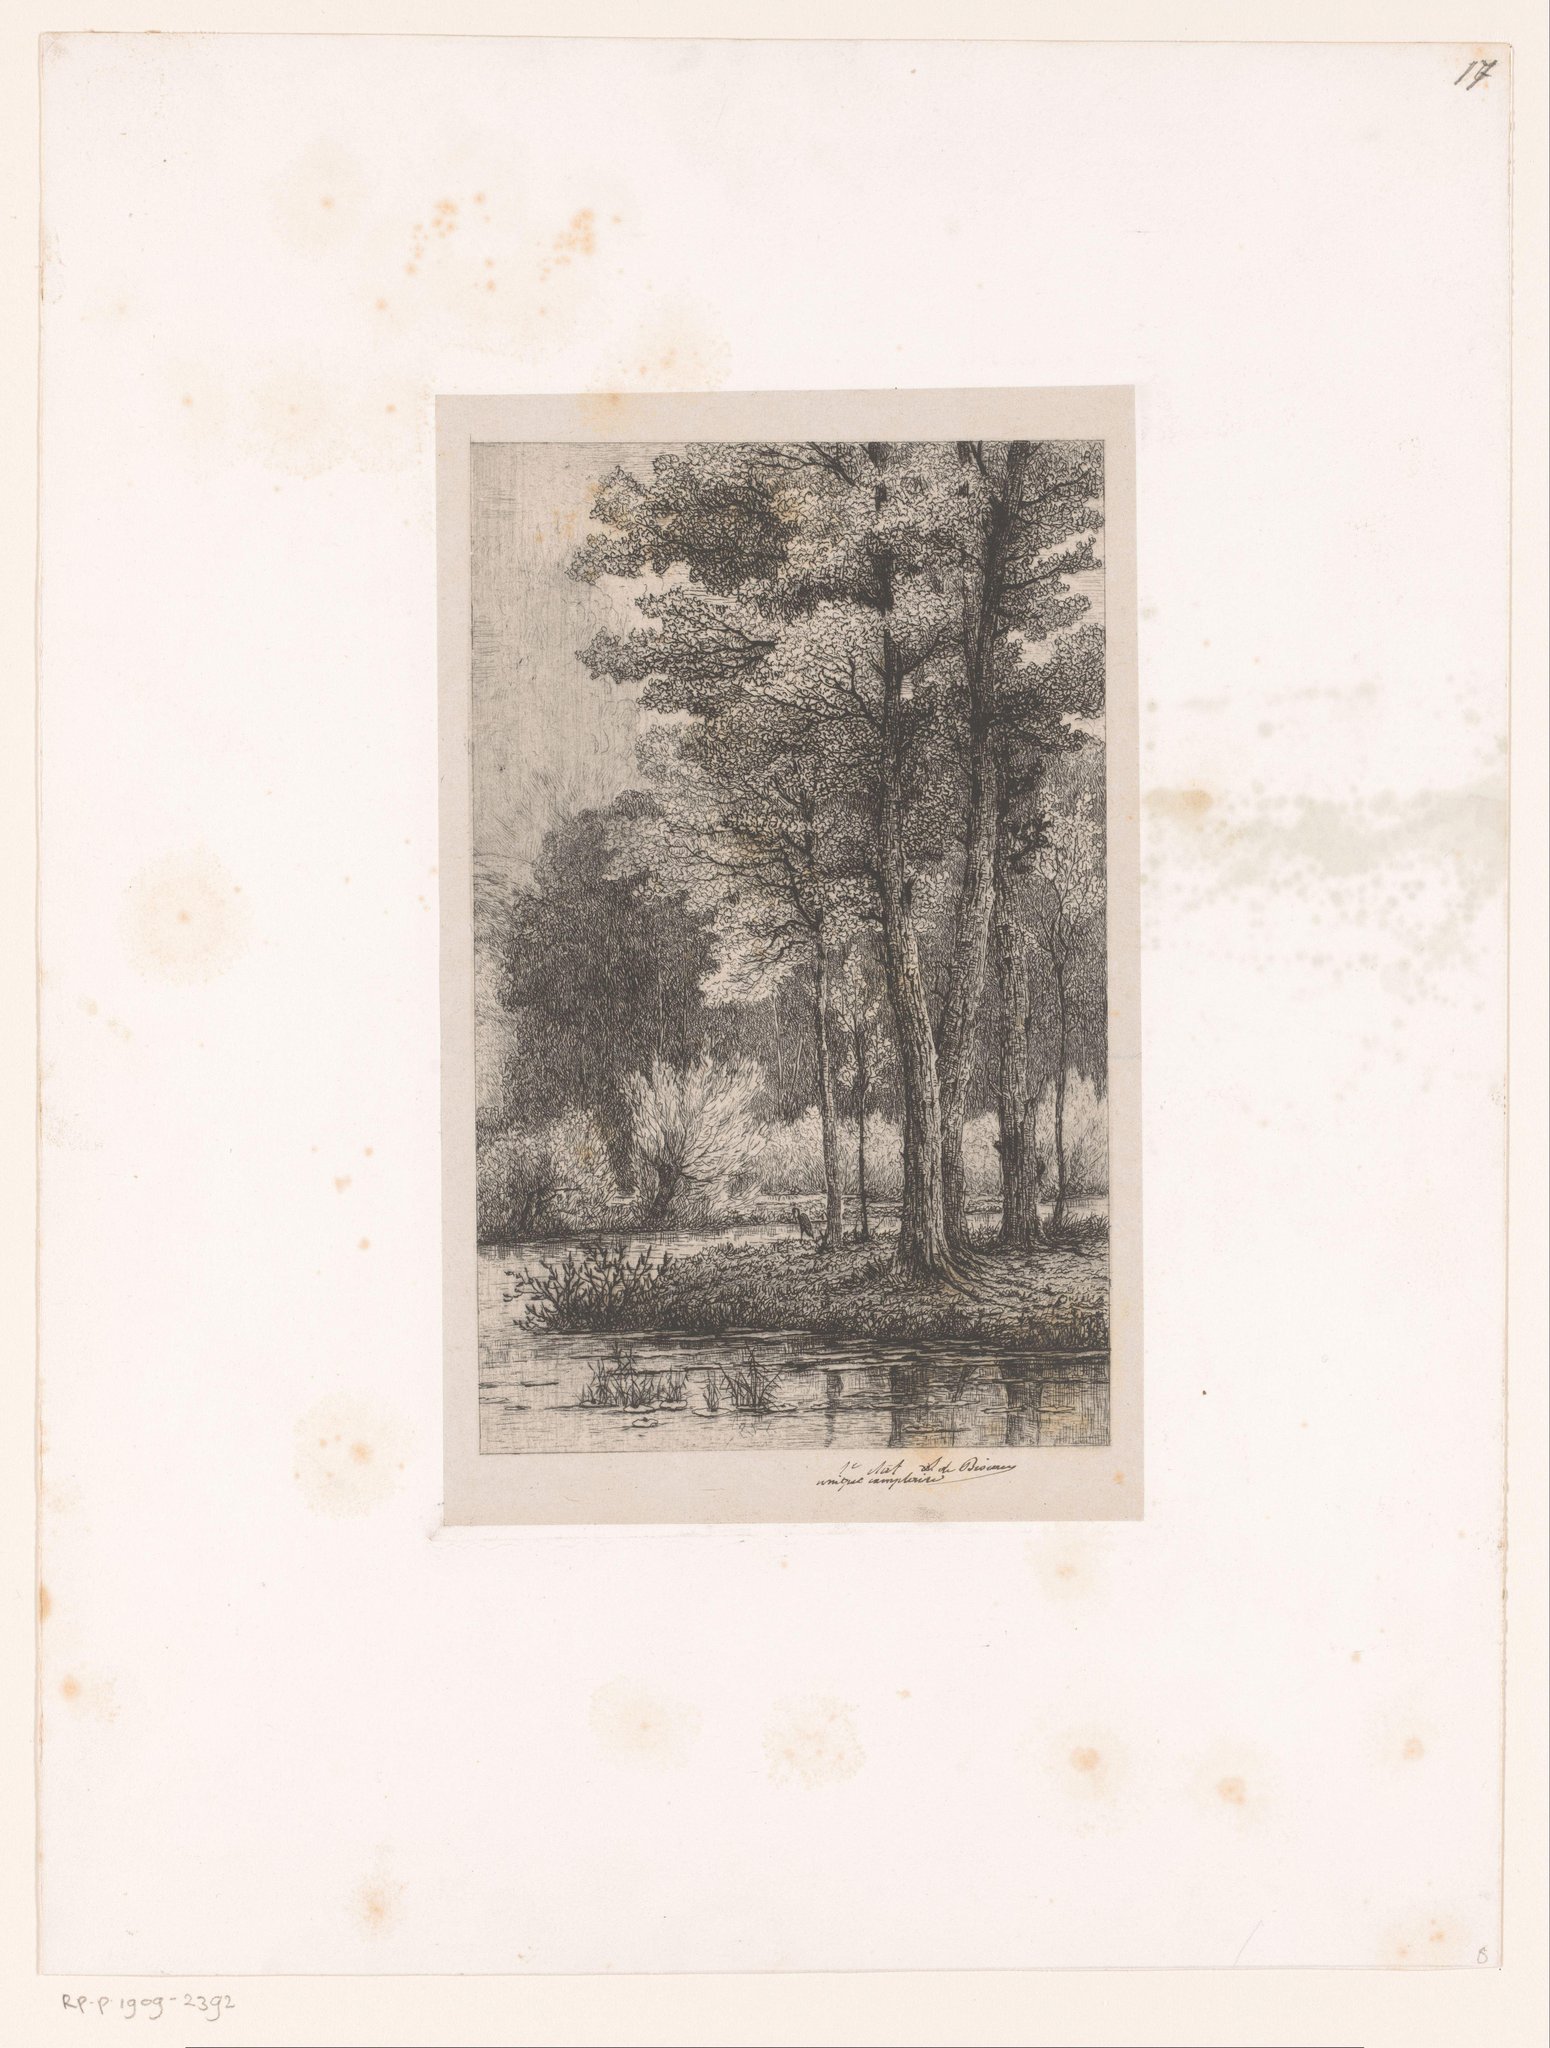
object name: print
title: Bomen aan het water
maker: aristide de biseau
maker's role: print maker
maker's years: 1844-1883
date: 1875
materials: paper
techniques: etching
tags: trees, landscapes, shore-birds and wading-birds: heron, pond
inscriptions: inscription: ‘1e etat unique exemplaire’, collector's mark: Lugt 2228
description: Een latere staat van deze prent is gebruikt in: Album du Journal des Beaux-Arts. Antwerpen, s.n., 1875.